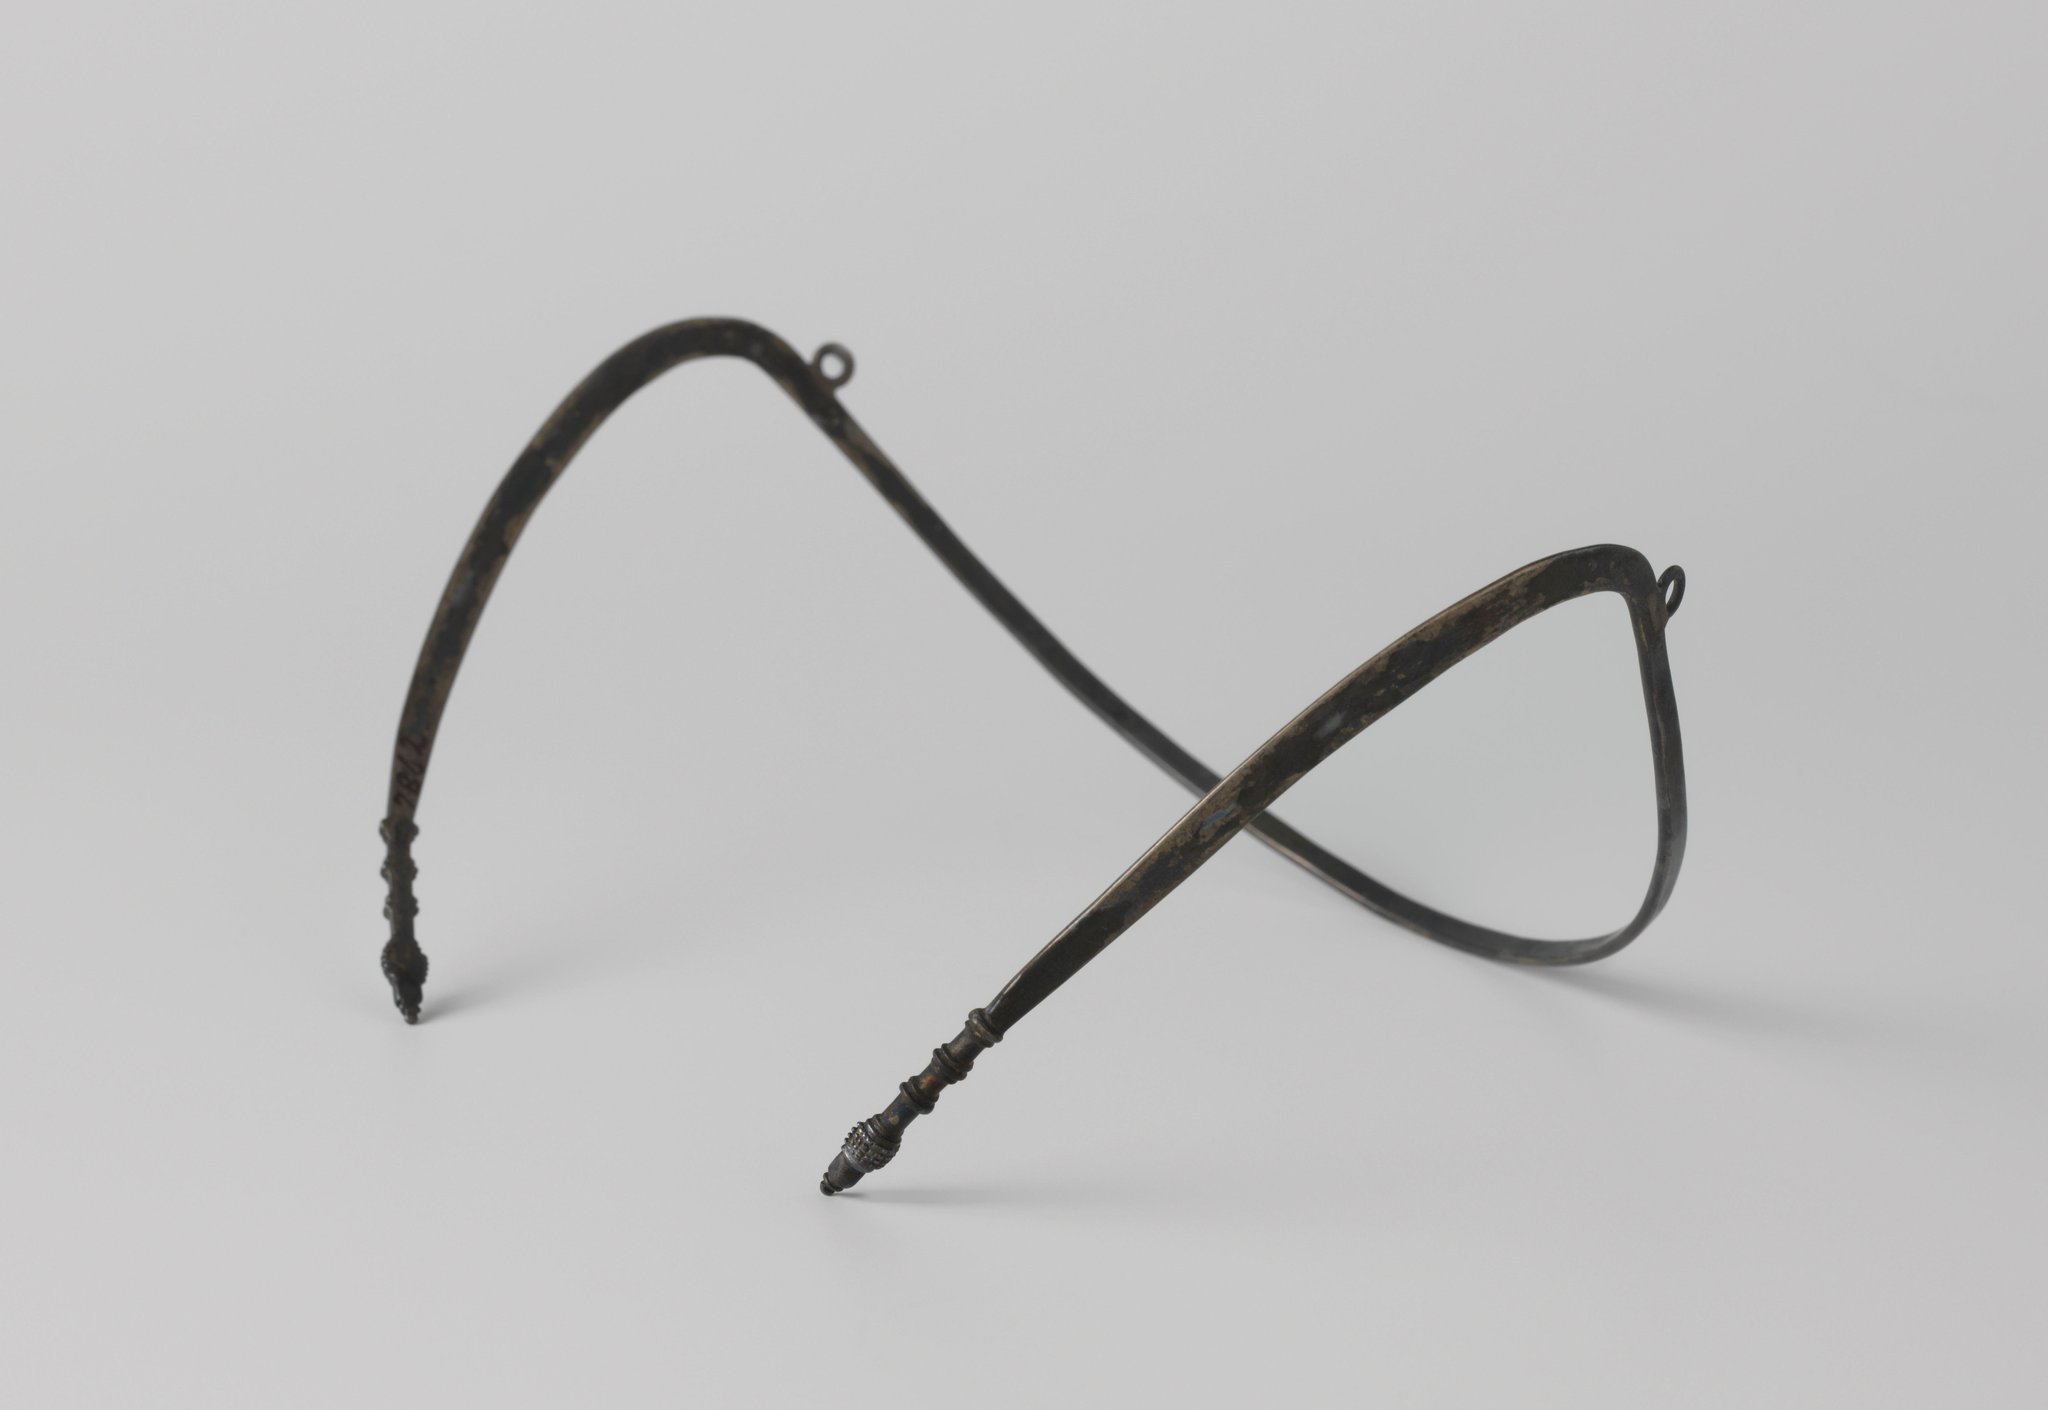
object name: oorijzer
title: Oorijzer van zilver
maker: Anonymous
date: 1600-1699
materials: silver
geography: netherlands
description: Een ronde platte band met aan de uiteinden geprofileerde knoppen.